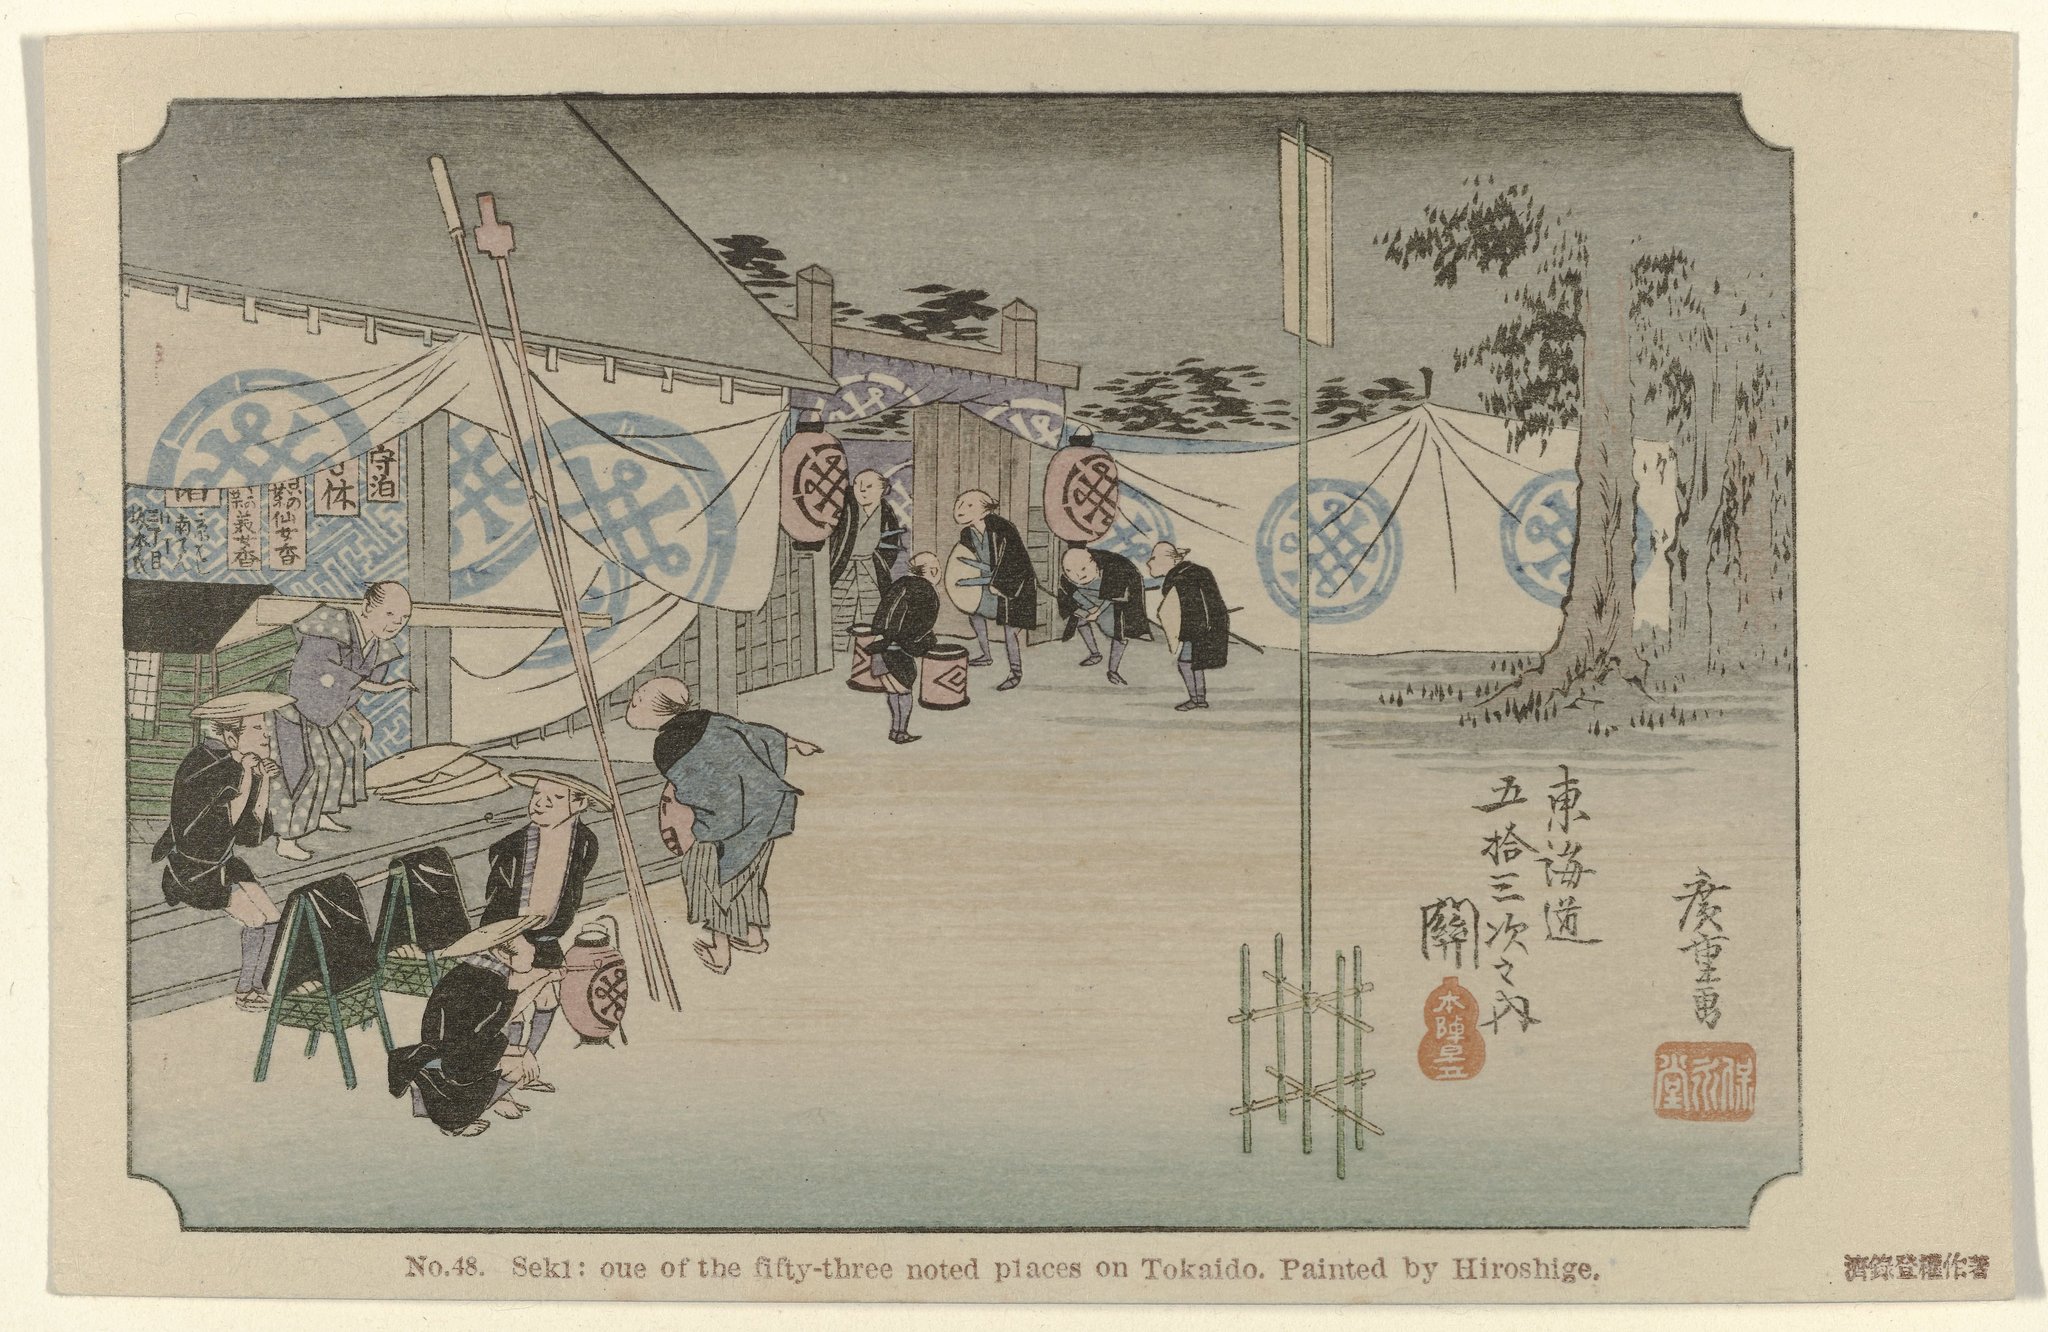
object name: ansichtkaart, prentbriefkaart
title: Seki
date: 1906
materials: cardboard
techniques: woodcut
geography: japan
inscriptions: date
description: Scene buiten een rustplek langs de Tôkaidô waar een krijgsheer (daimyo) is gestopt voor de nacht.